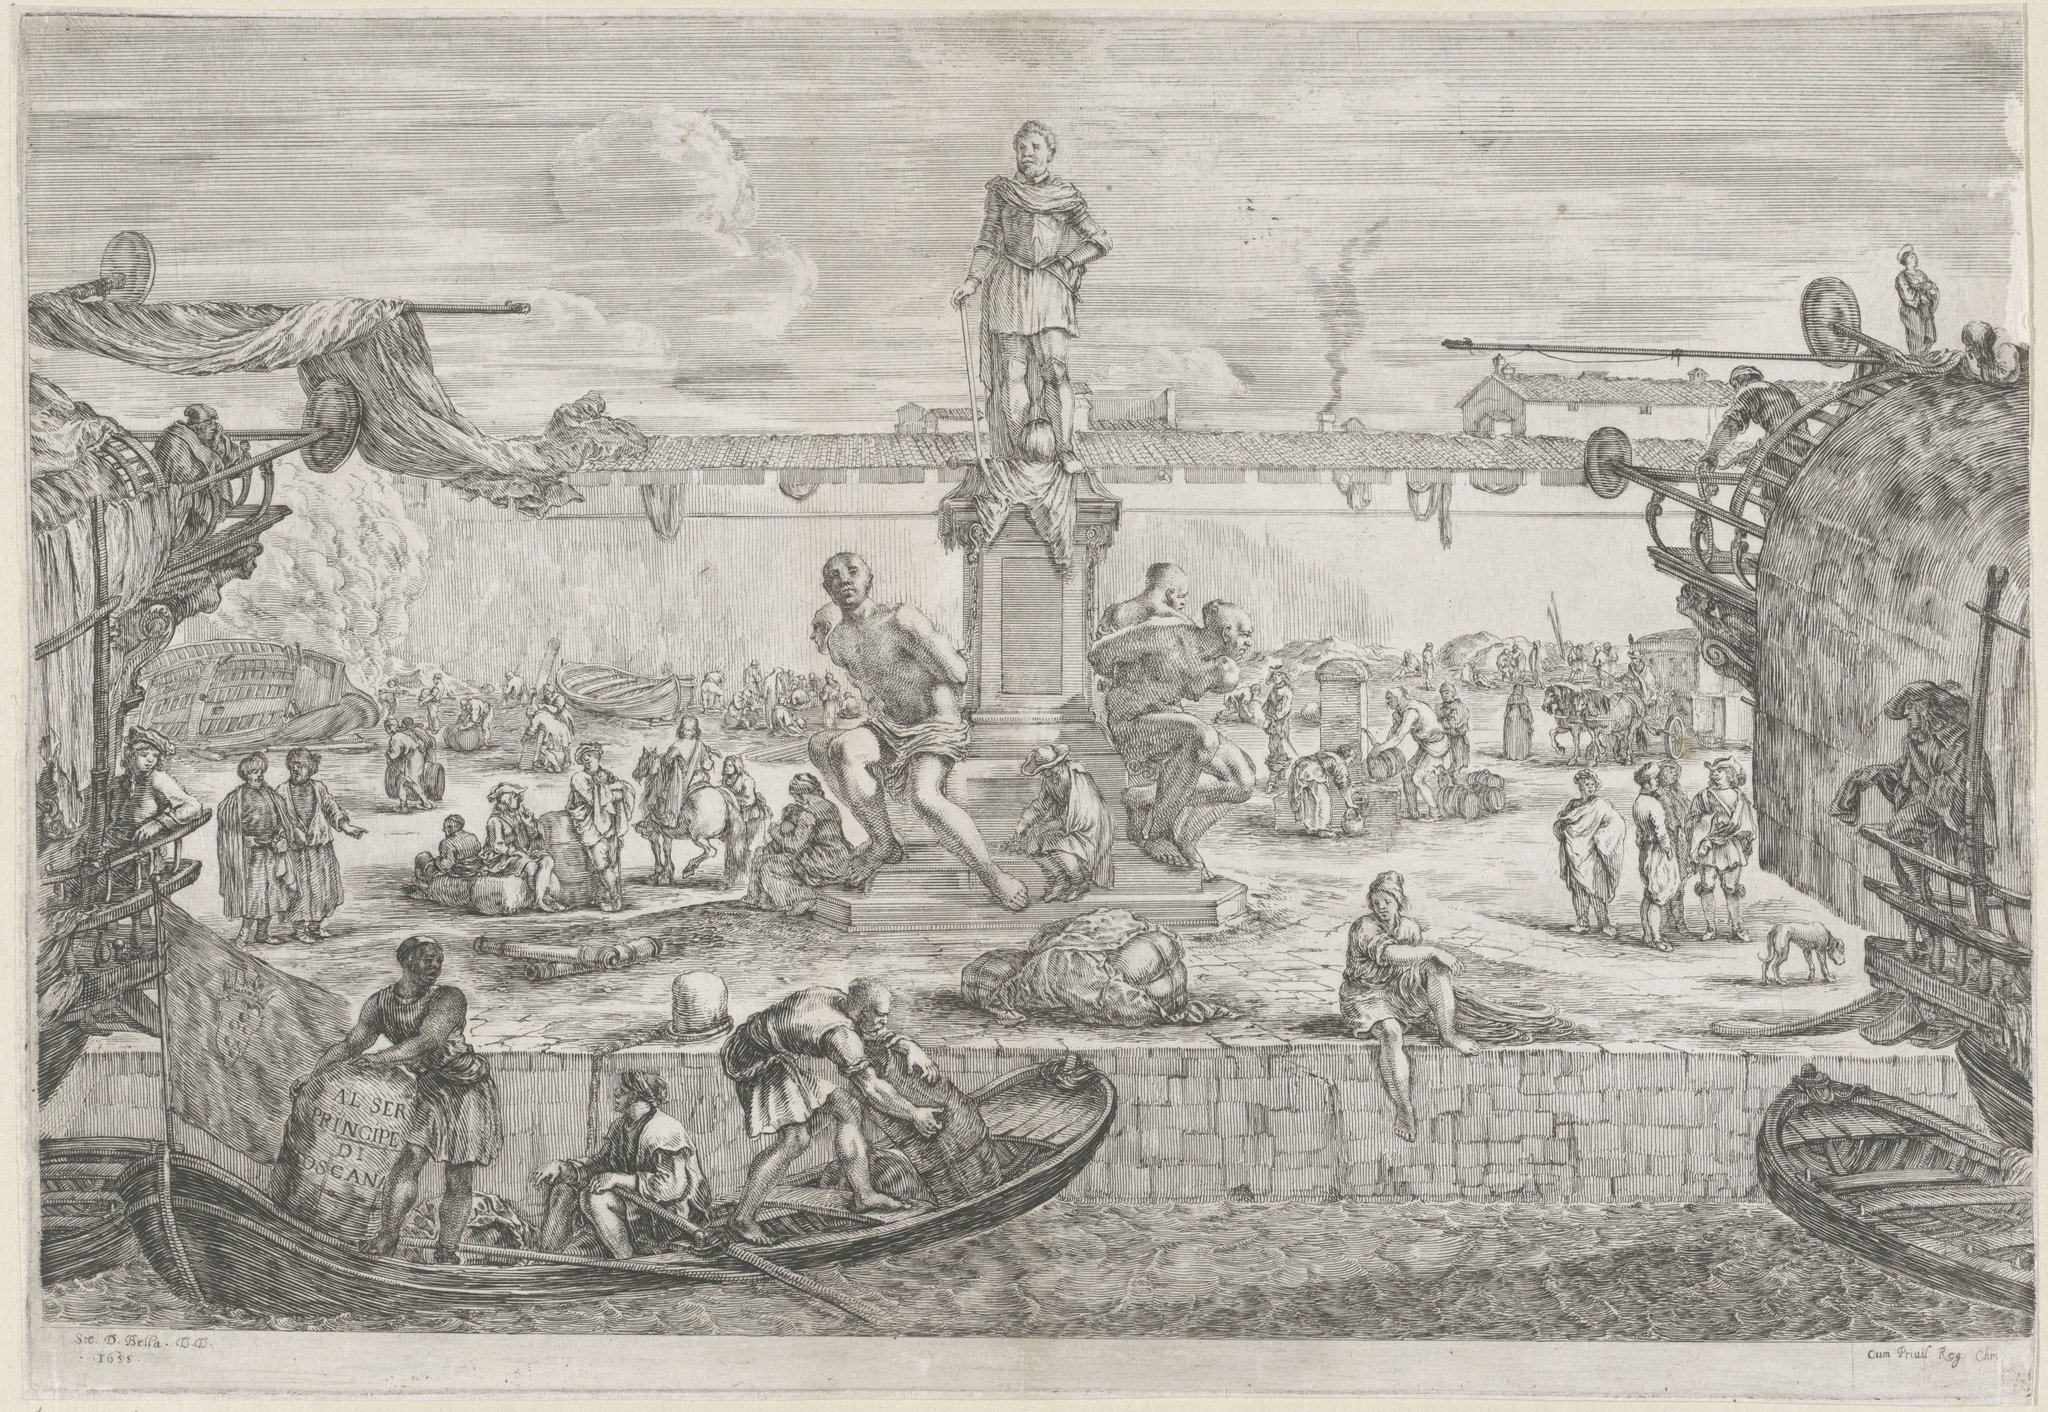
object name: print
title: Haven van Livorno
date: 1655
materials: paper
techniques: etching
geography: livorno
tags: ferdinando i de' medici, harbour, dock labourer, ships (in general), slavery; serfs and enslaved persons, piece of sculpture, reproduction of a piece of sculpture, merchant, salesman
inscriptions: collector's mark: Lugt 240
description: Zicht op de haven van Livorno met het standbeeld van Ferdinand I, groothertog van Toscane, met op de hoeken de beelden van de vier tot slaaf gemaakte 'Moren' (I Quattro Mori). Op de kade bevinden zich handelaren, havenarbeiders en zeelieden. Links en rechts twee achterkanten van aangemeerde schepen.